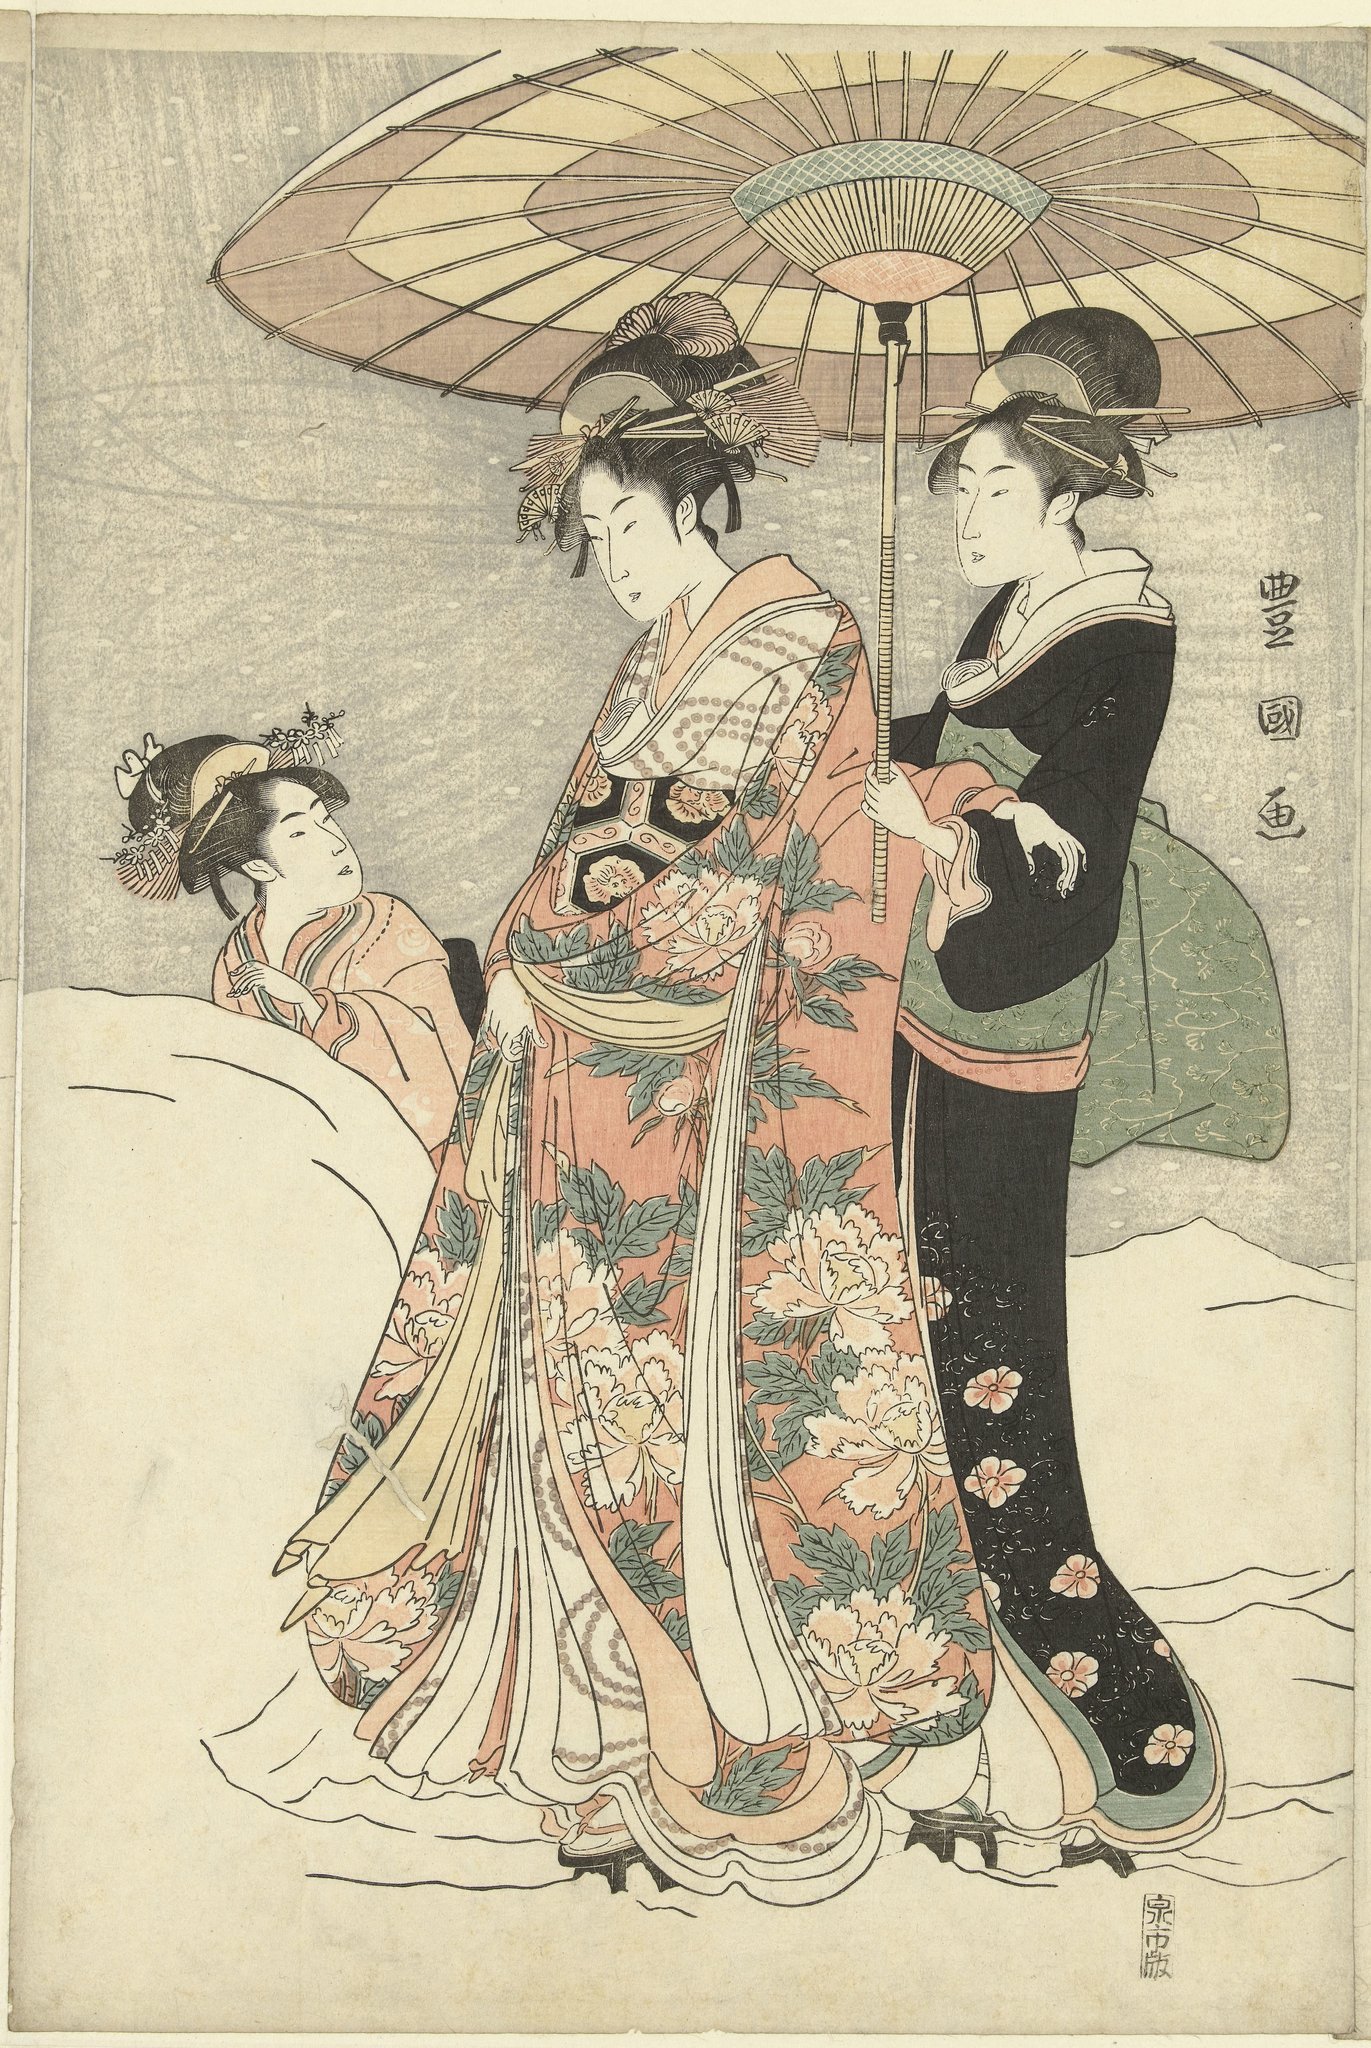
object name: print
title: Sneeuwbal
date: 1794-1798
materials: paper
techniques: woodcut, nishiki e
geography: tokyo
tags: rolling up a snowball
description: Elegant geklede courtisane in kimono met patroon van pioenrozen, onder paraplu vastgehouden door shinzo (courtisane in opleiding) in zwarte kimono, kijkend naar kamuro (jongste hulp van courtisane) een grote sneeuwbal rollend; tegen grijze achtergrond met dwarrelende sneeuwvlokken.